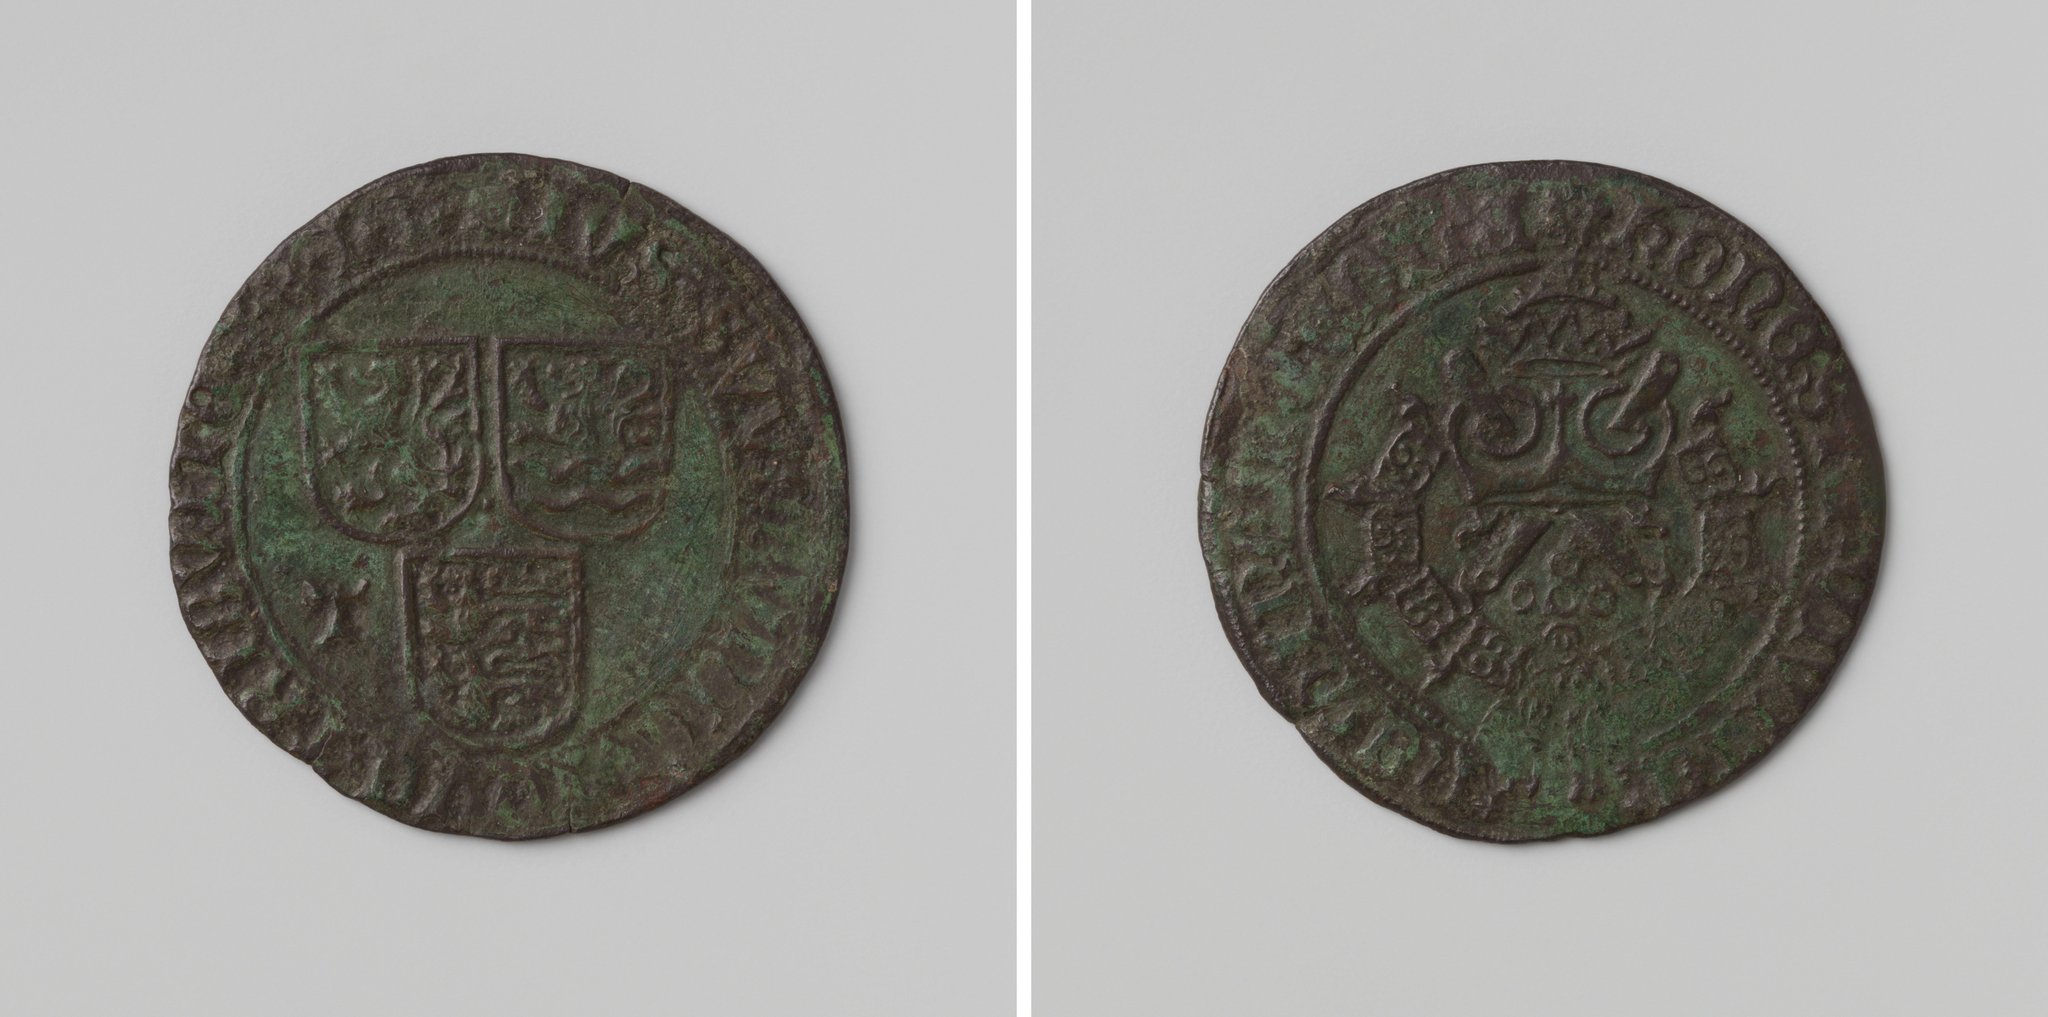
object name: jeton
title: Bourgondische heerschappij over Holland, Zeeland en Friesland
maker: Anonymous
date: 1512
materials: copper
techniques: striking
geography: netherlands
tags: zeeland, holland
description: Koperen penning. Voorzijde: twee wapenschilden, geplaatst boven derde wapenschild onder letter T binnen omschrift. Keerzijde: gekroonde vuurslag op Bourgondisch kruis, omhangen met ordeteken van Gulden Vlies binnen omschrift